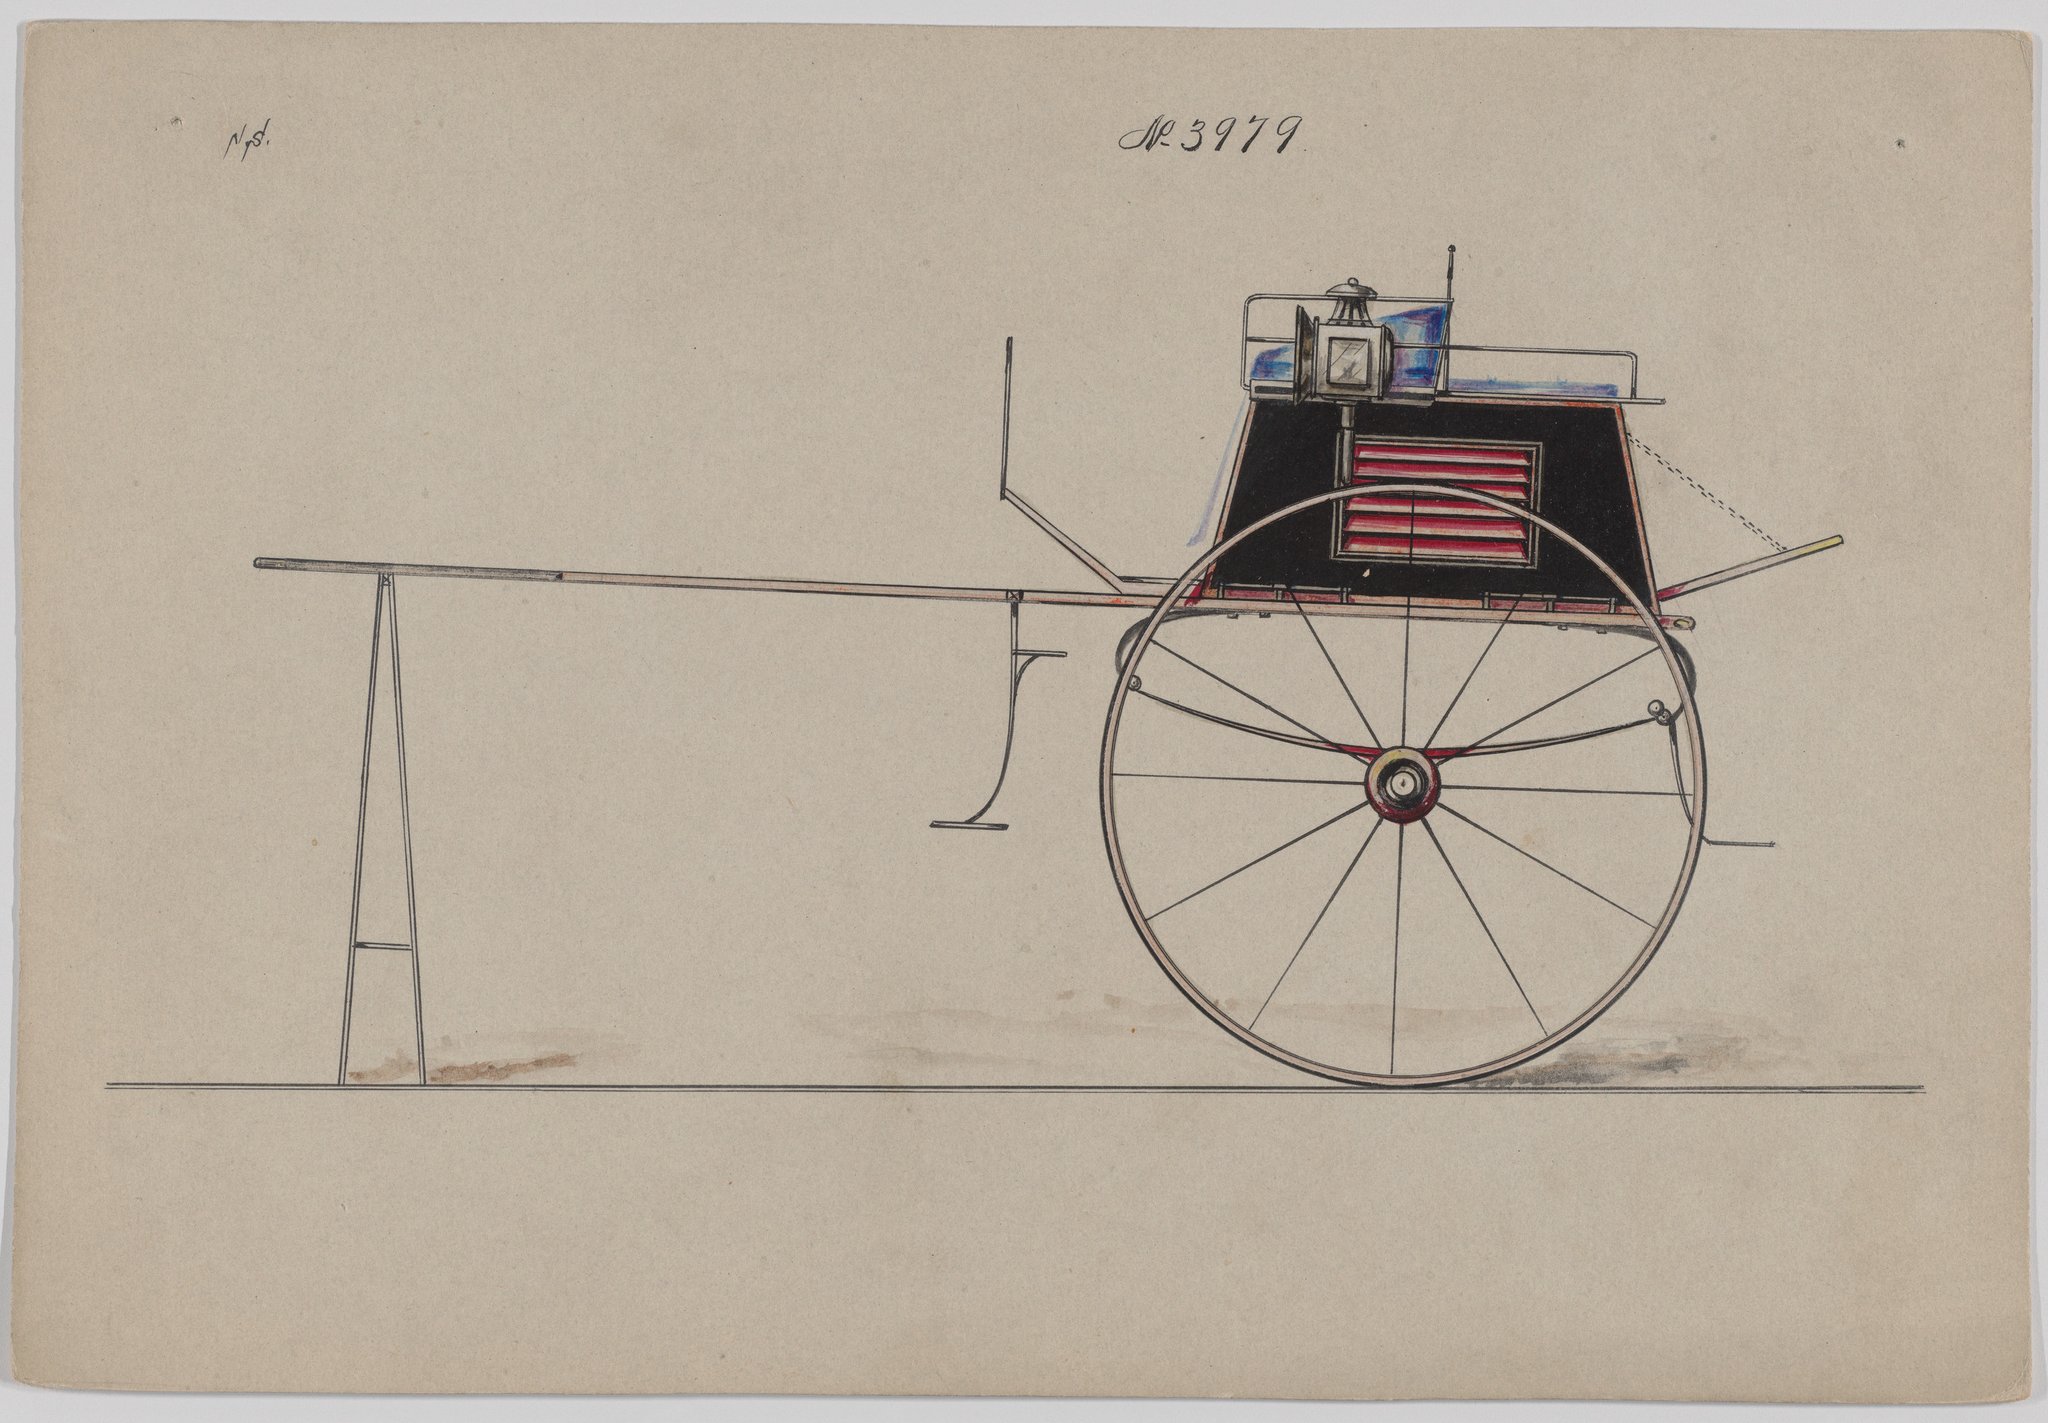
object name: drawing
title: Design for Dog Cart or 2 Wheeler, no. 3979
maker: brewster & co.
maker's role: manufacturer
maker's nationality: american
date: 1886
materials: gouache, gum arabic, ink, watercolor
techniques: pen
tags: carriages